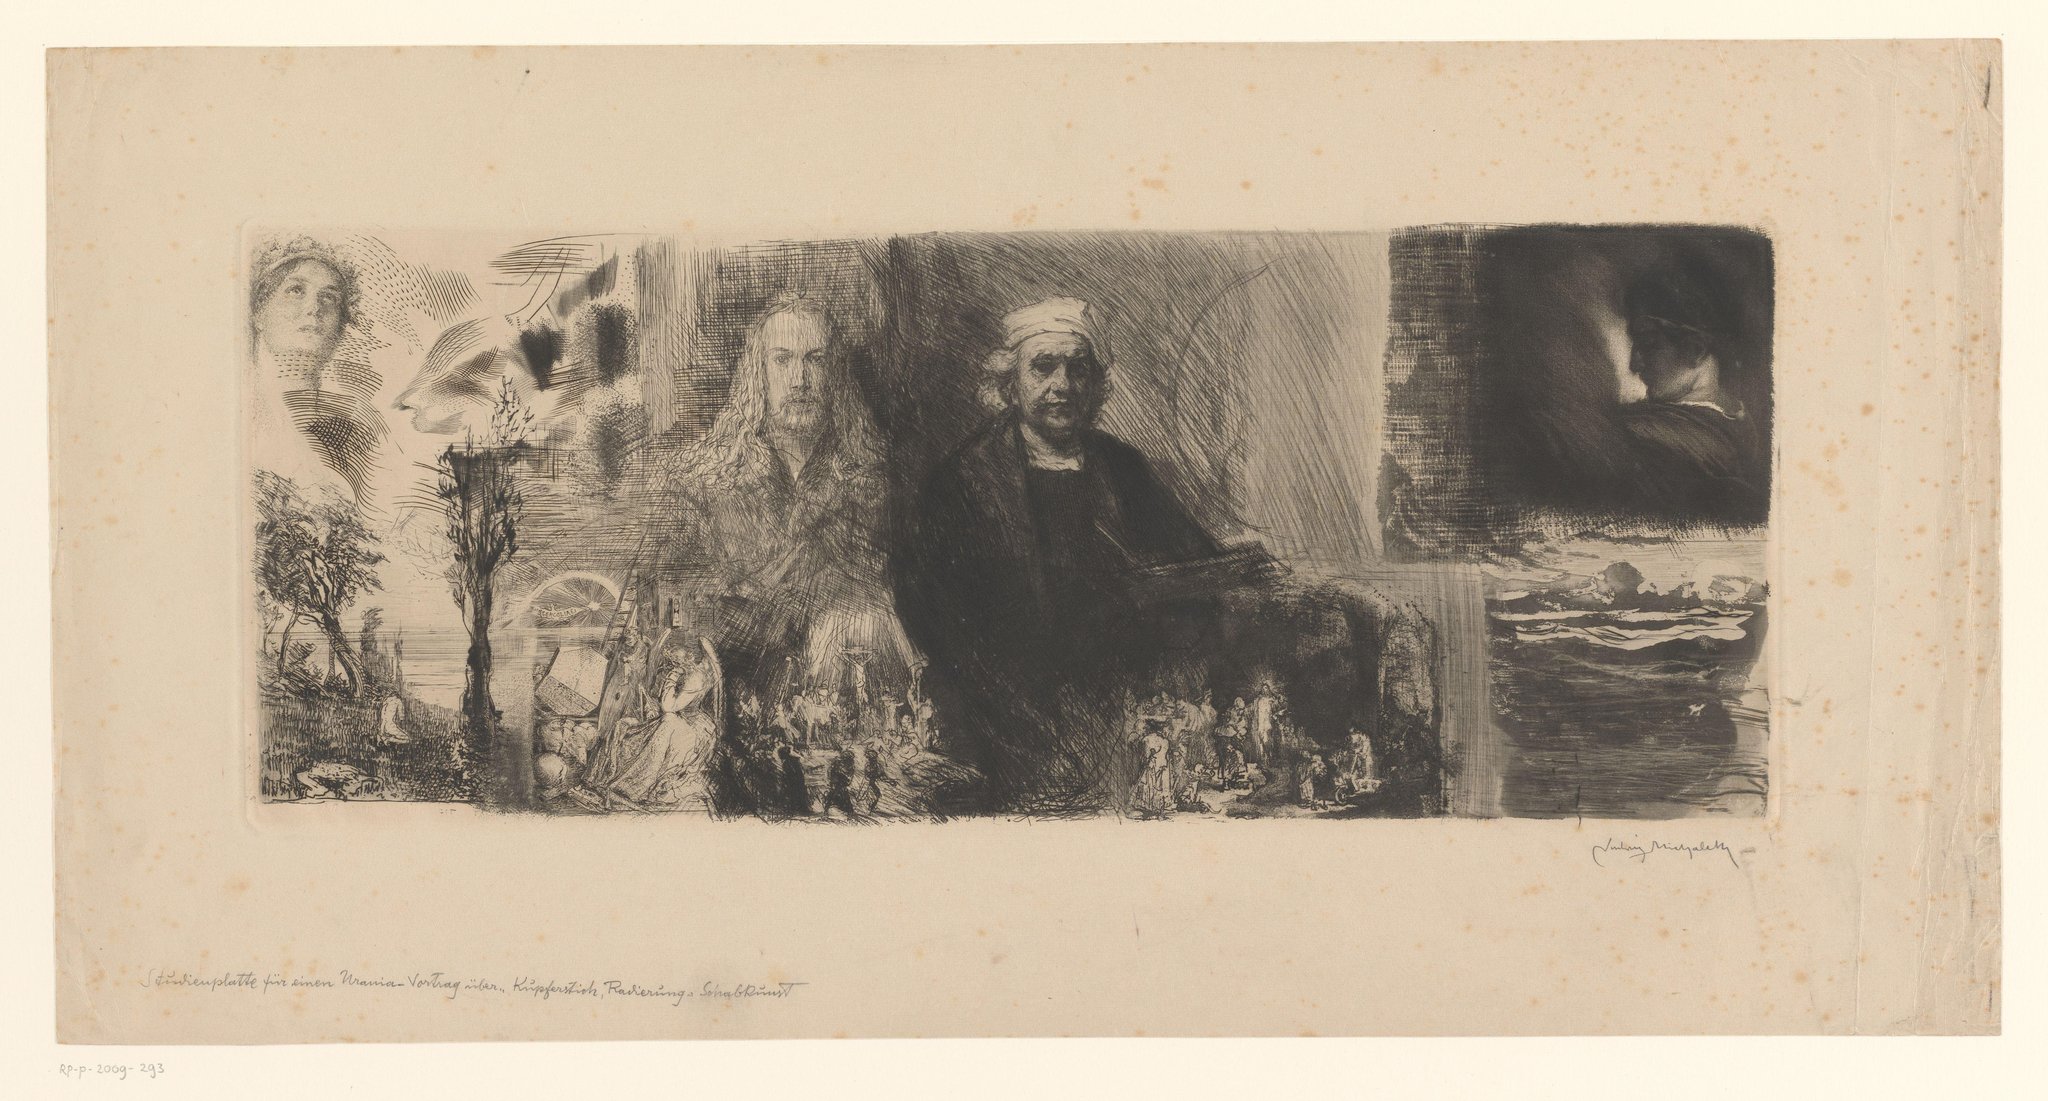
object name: print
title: An die Schönheit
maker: ludwig michalek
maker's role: print maker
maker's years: 1859-1942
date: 1898-1920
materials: paper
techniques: aquatint, drypoint, engraving, etching, roulette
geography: vienna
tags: leiden, amsterdam, painter, print maker, draughtsman, rembrandt van rijn, albrecht dürer, portrait, self-portrait of painter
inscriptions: collector's mark: Lugt 2228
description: Studieblad voor voordracht ('Urania-Vortrag') over prenttechnieken met reproducties van schilderijen en prenten van onder andere Albrecht Dürer ('Zelfportret' en 'Melancholia') en Rembrandt ('Zelfportret met cirkel', 'Drie kruisen' en 'Honderd Gulden prent'). De titel is gepreegd linksonder.